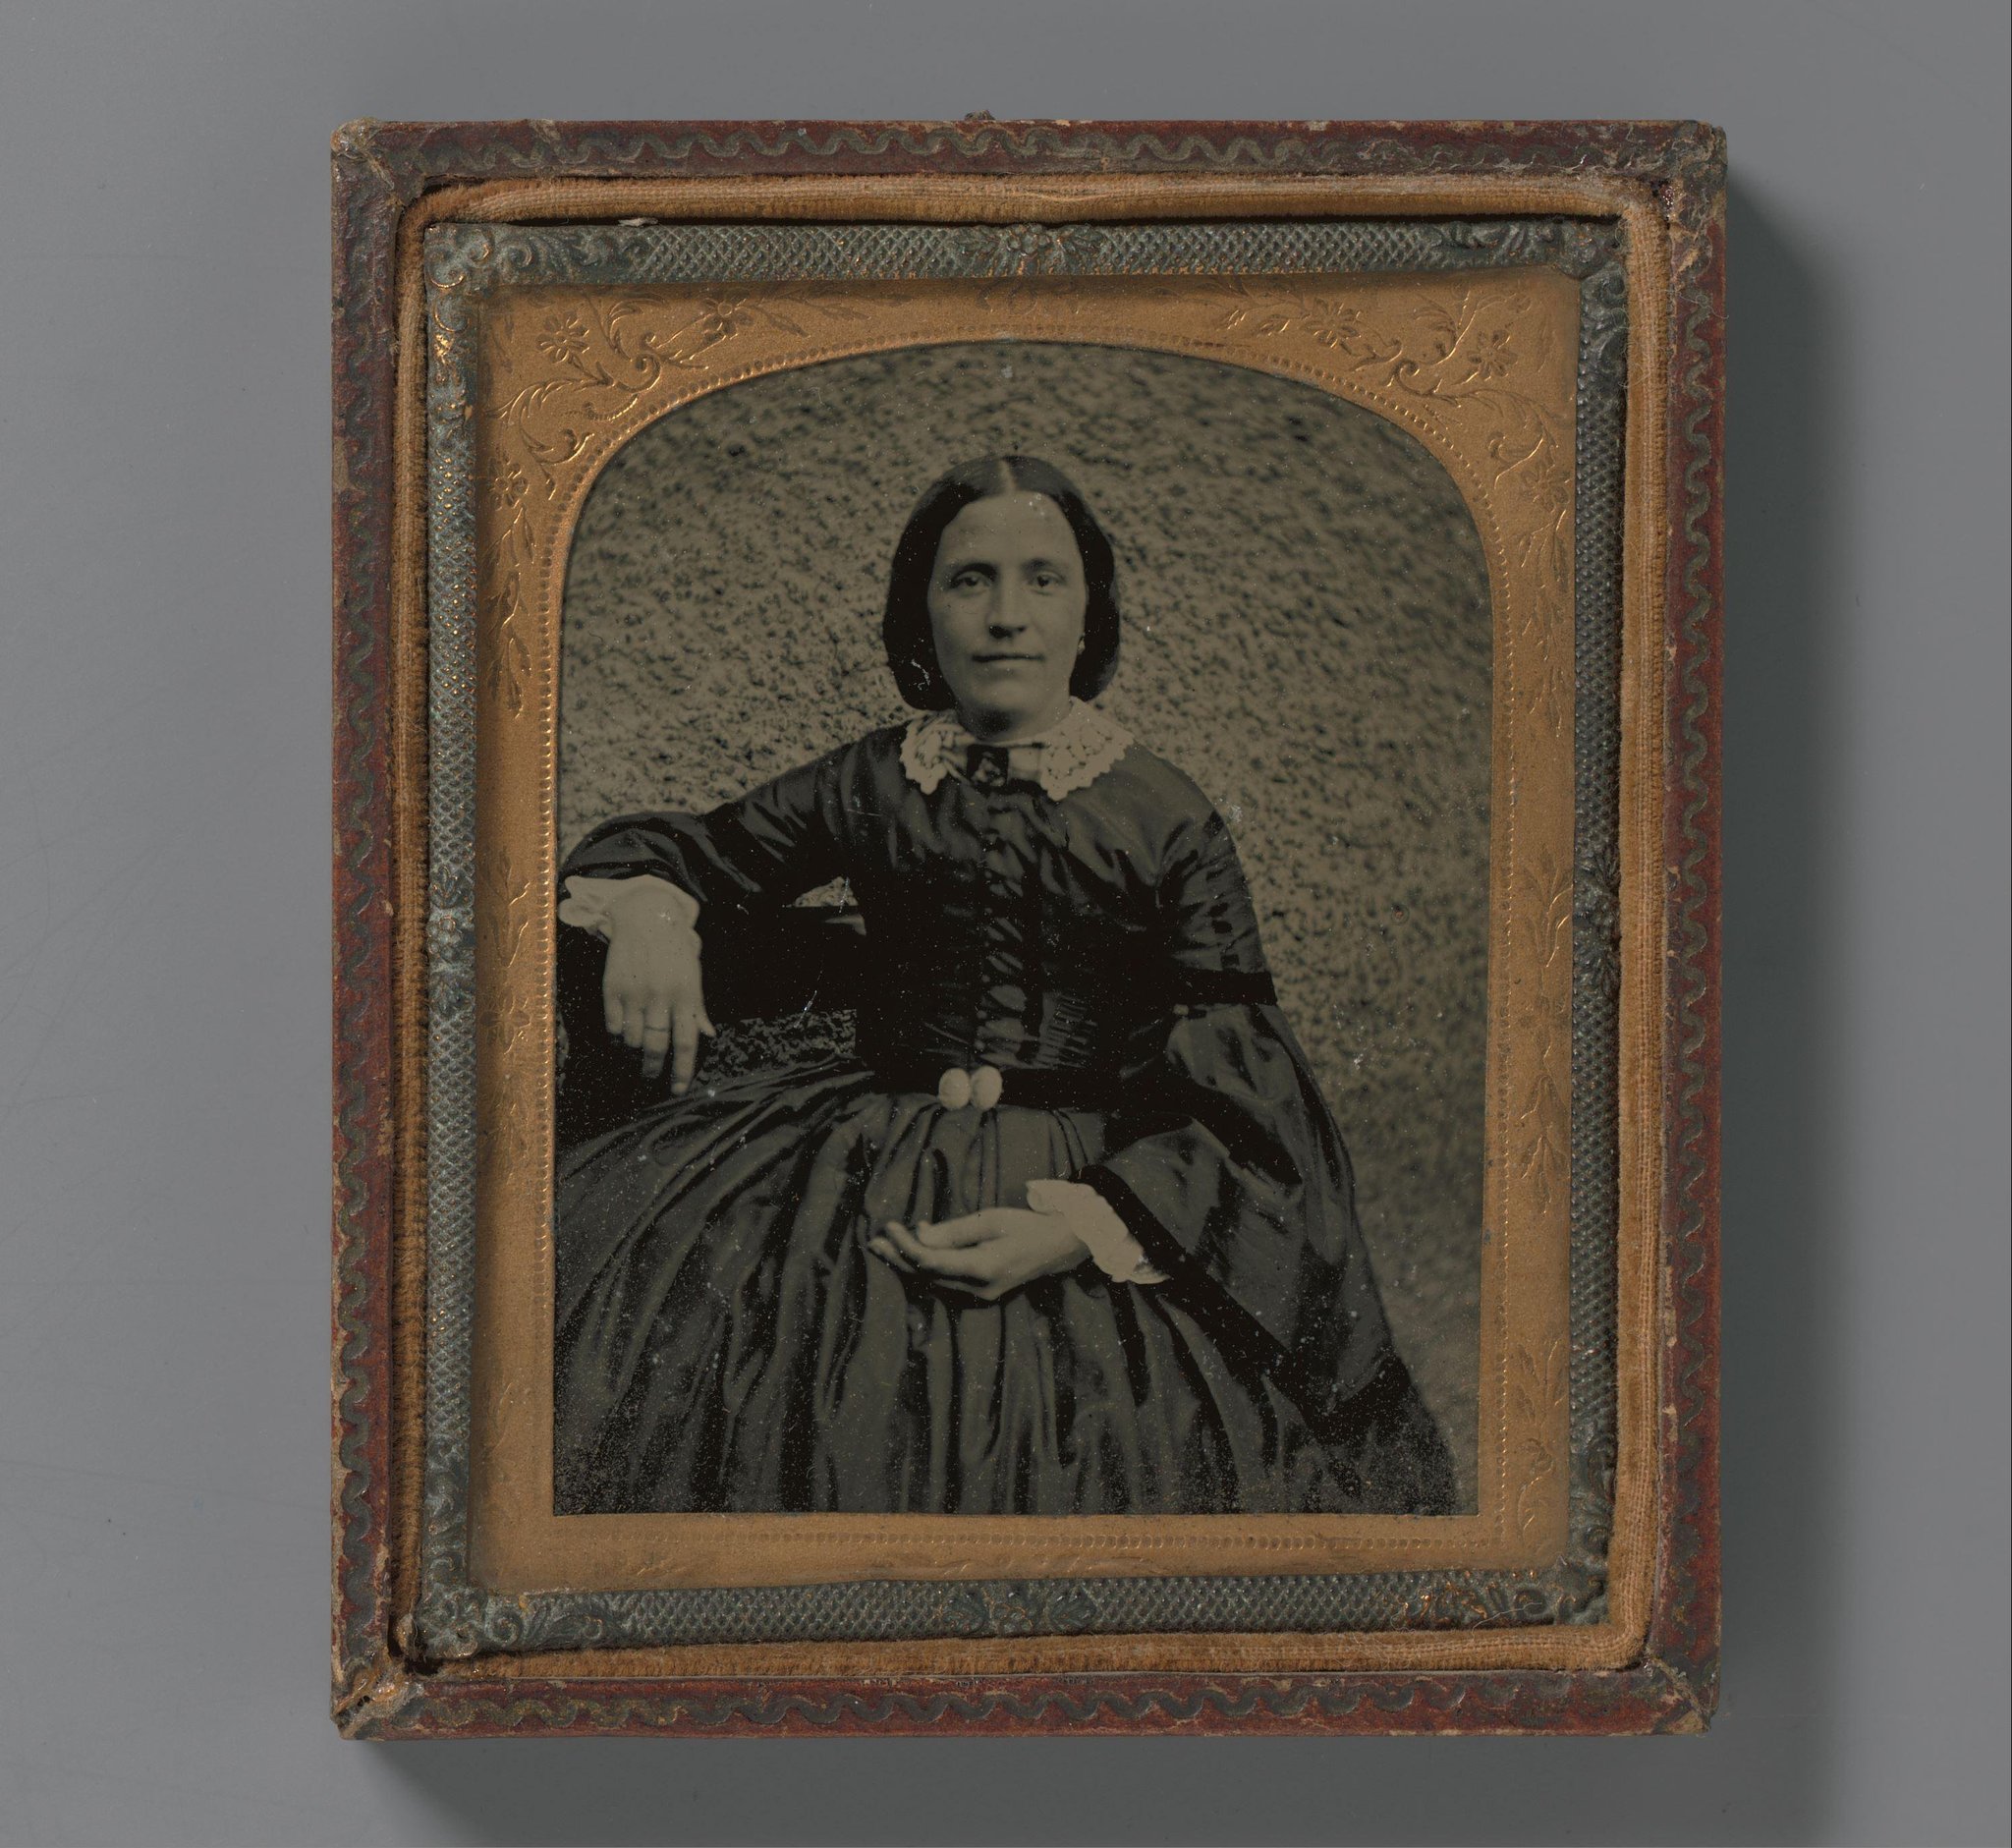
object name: photograph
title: Portret van een onbekende vrouw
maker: Anonymous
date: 1855-1870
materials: glass, metal, velvet, wood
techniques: ambrotype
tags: sitting figure - aa - female human figure, historical persons - bb - woman